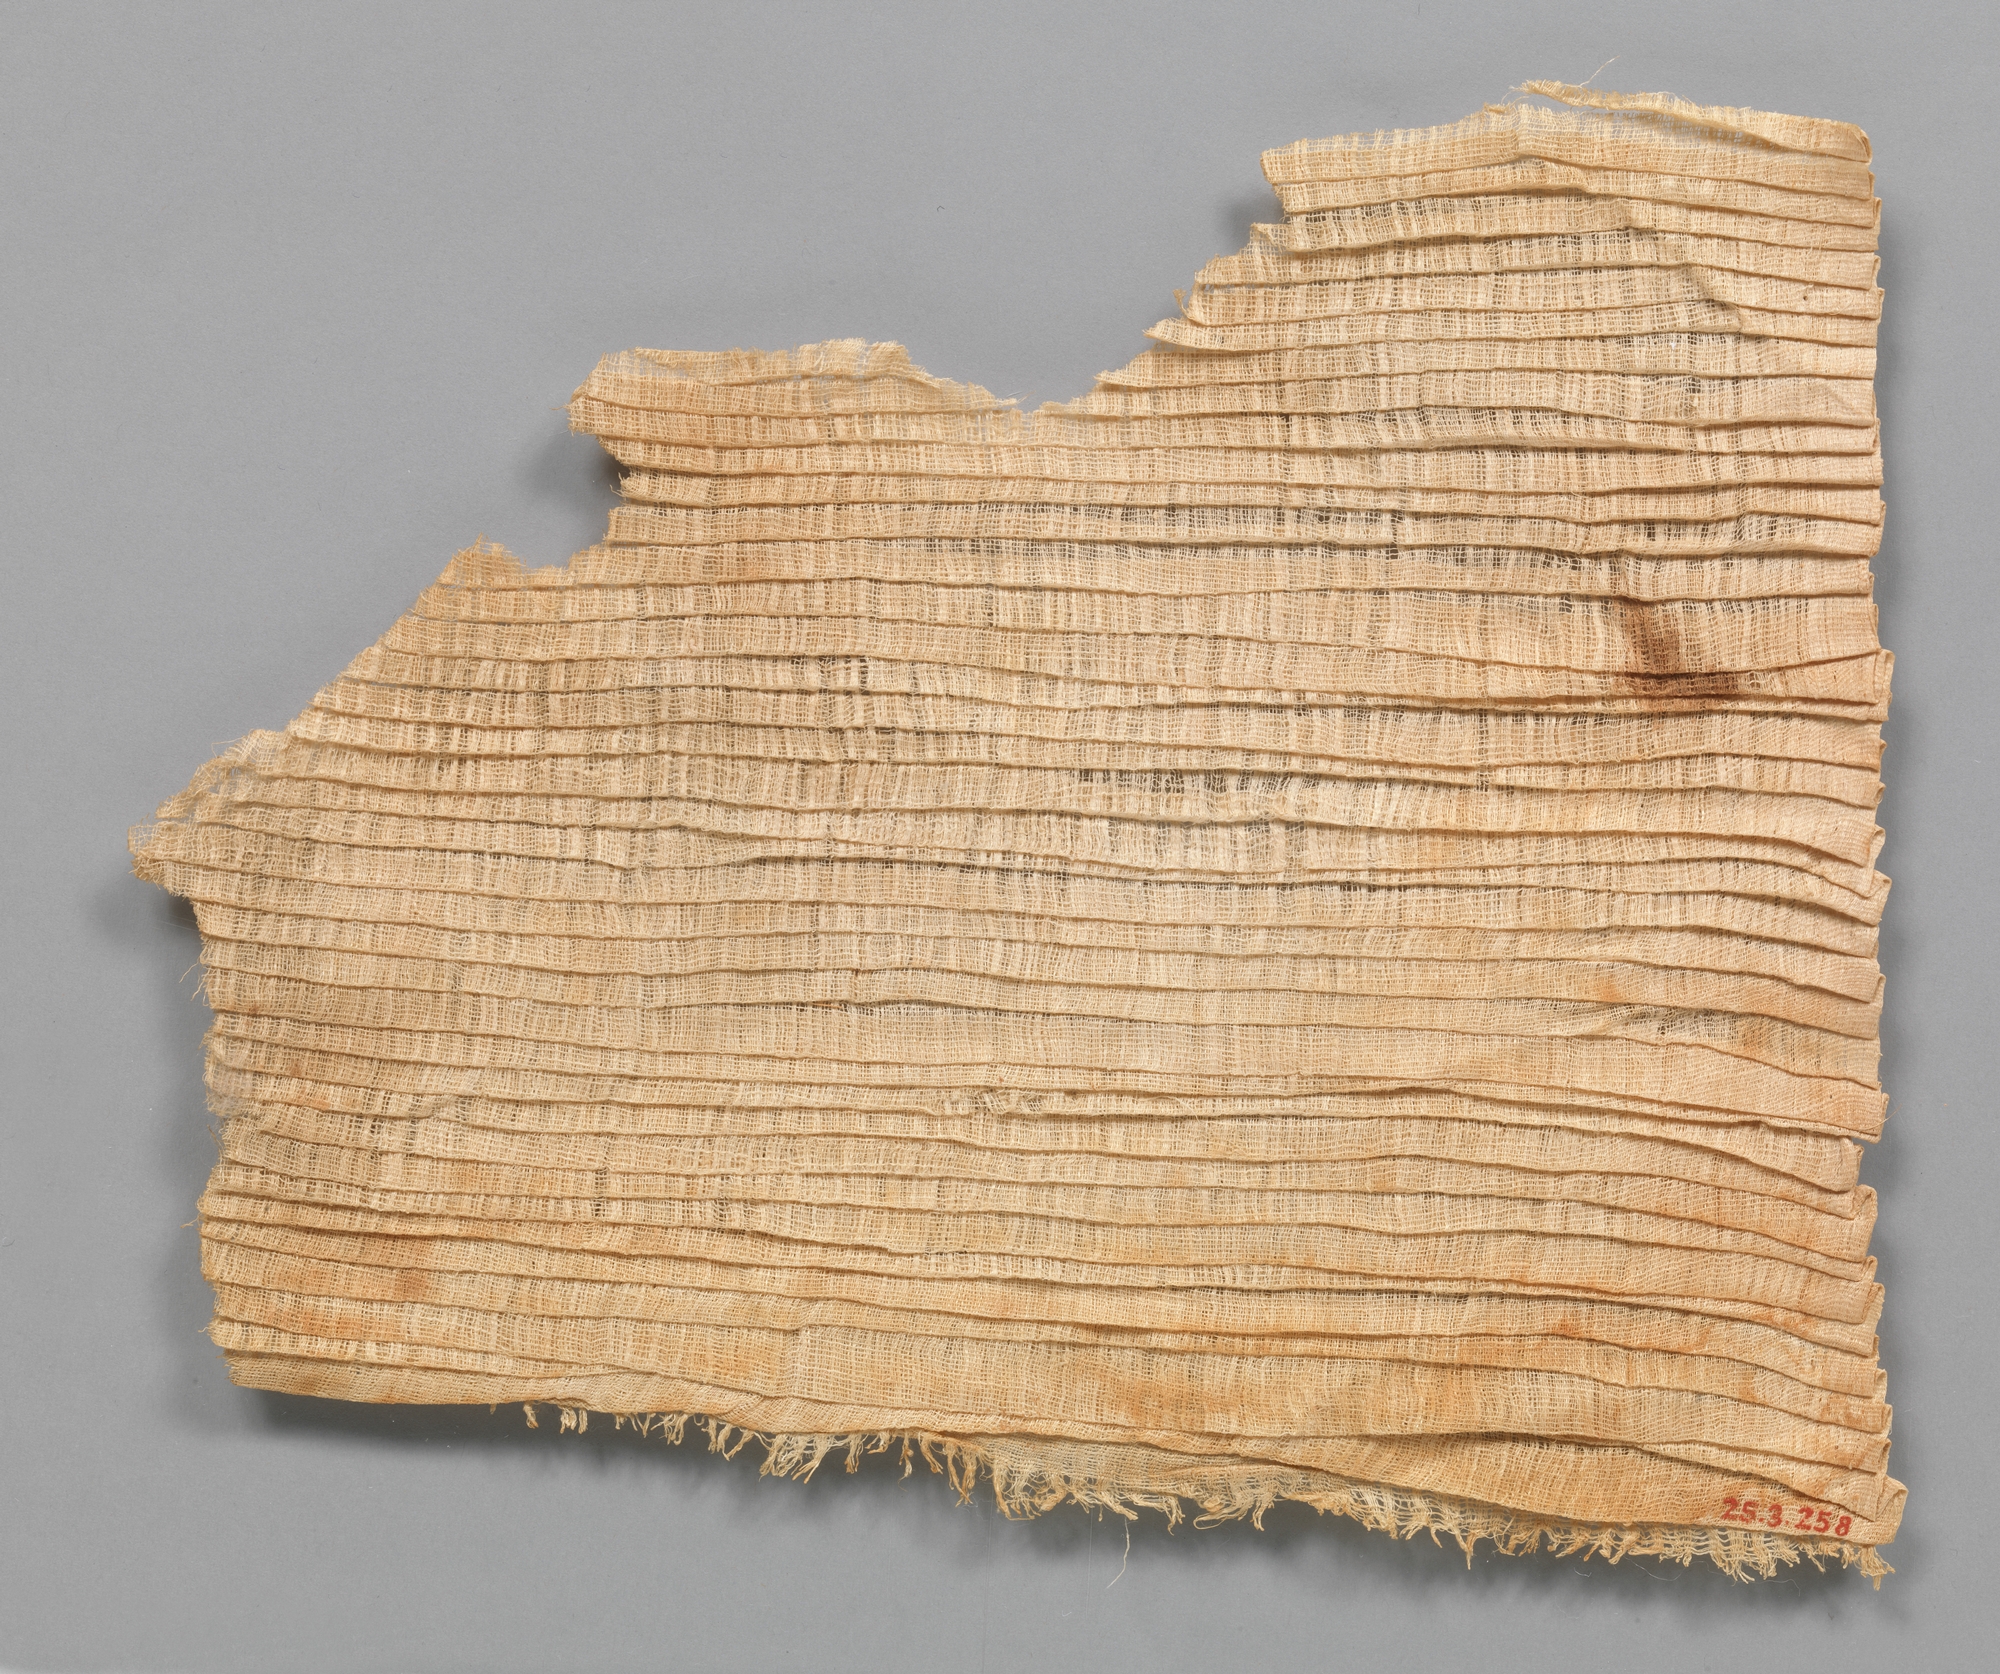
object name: sash or band, pleated, queen neferu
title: Corner of a pleated linen sheet of queen Neferu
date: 2051-2030 BCE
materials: linen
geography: egypt